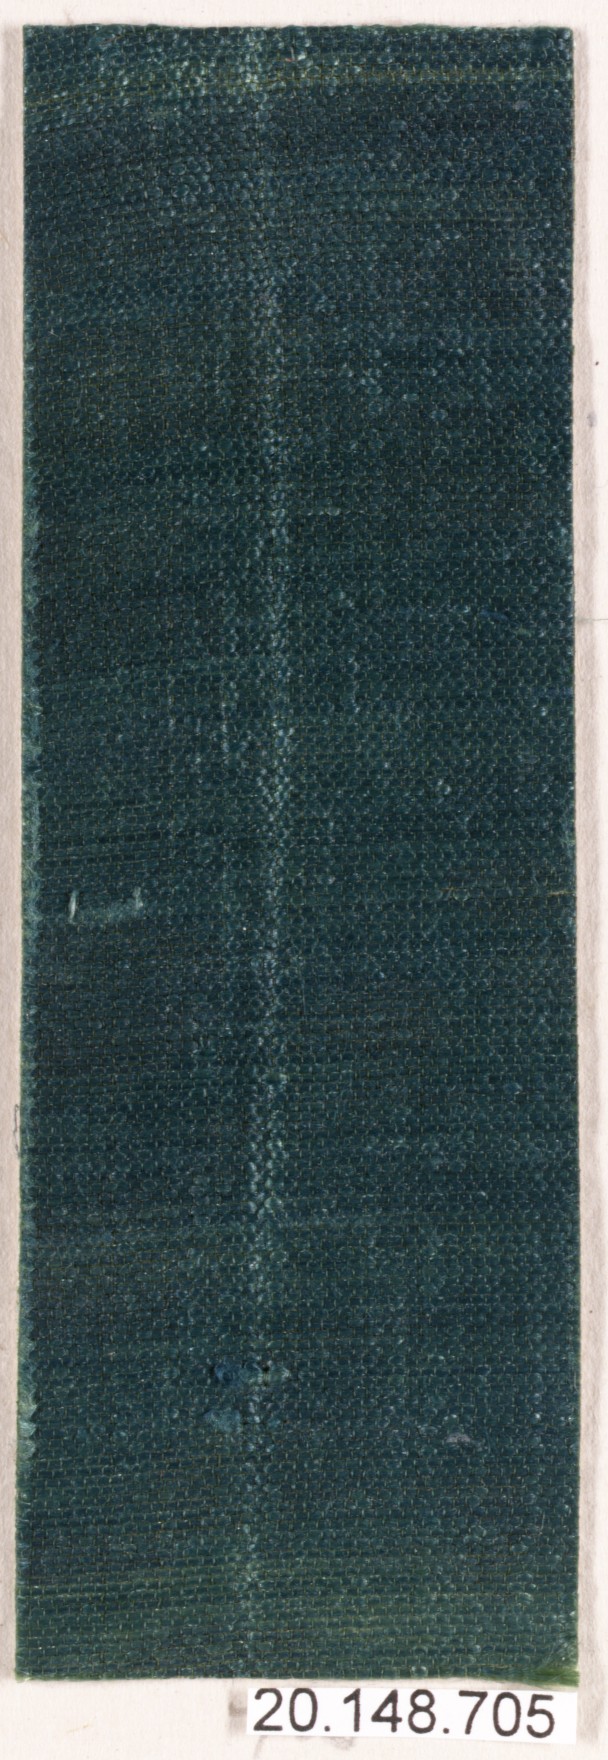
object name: piece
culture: japanese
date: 1701-1800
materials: silk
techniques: compound weave